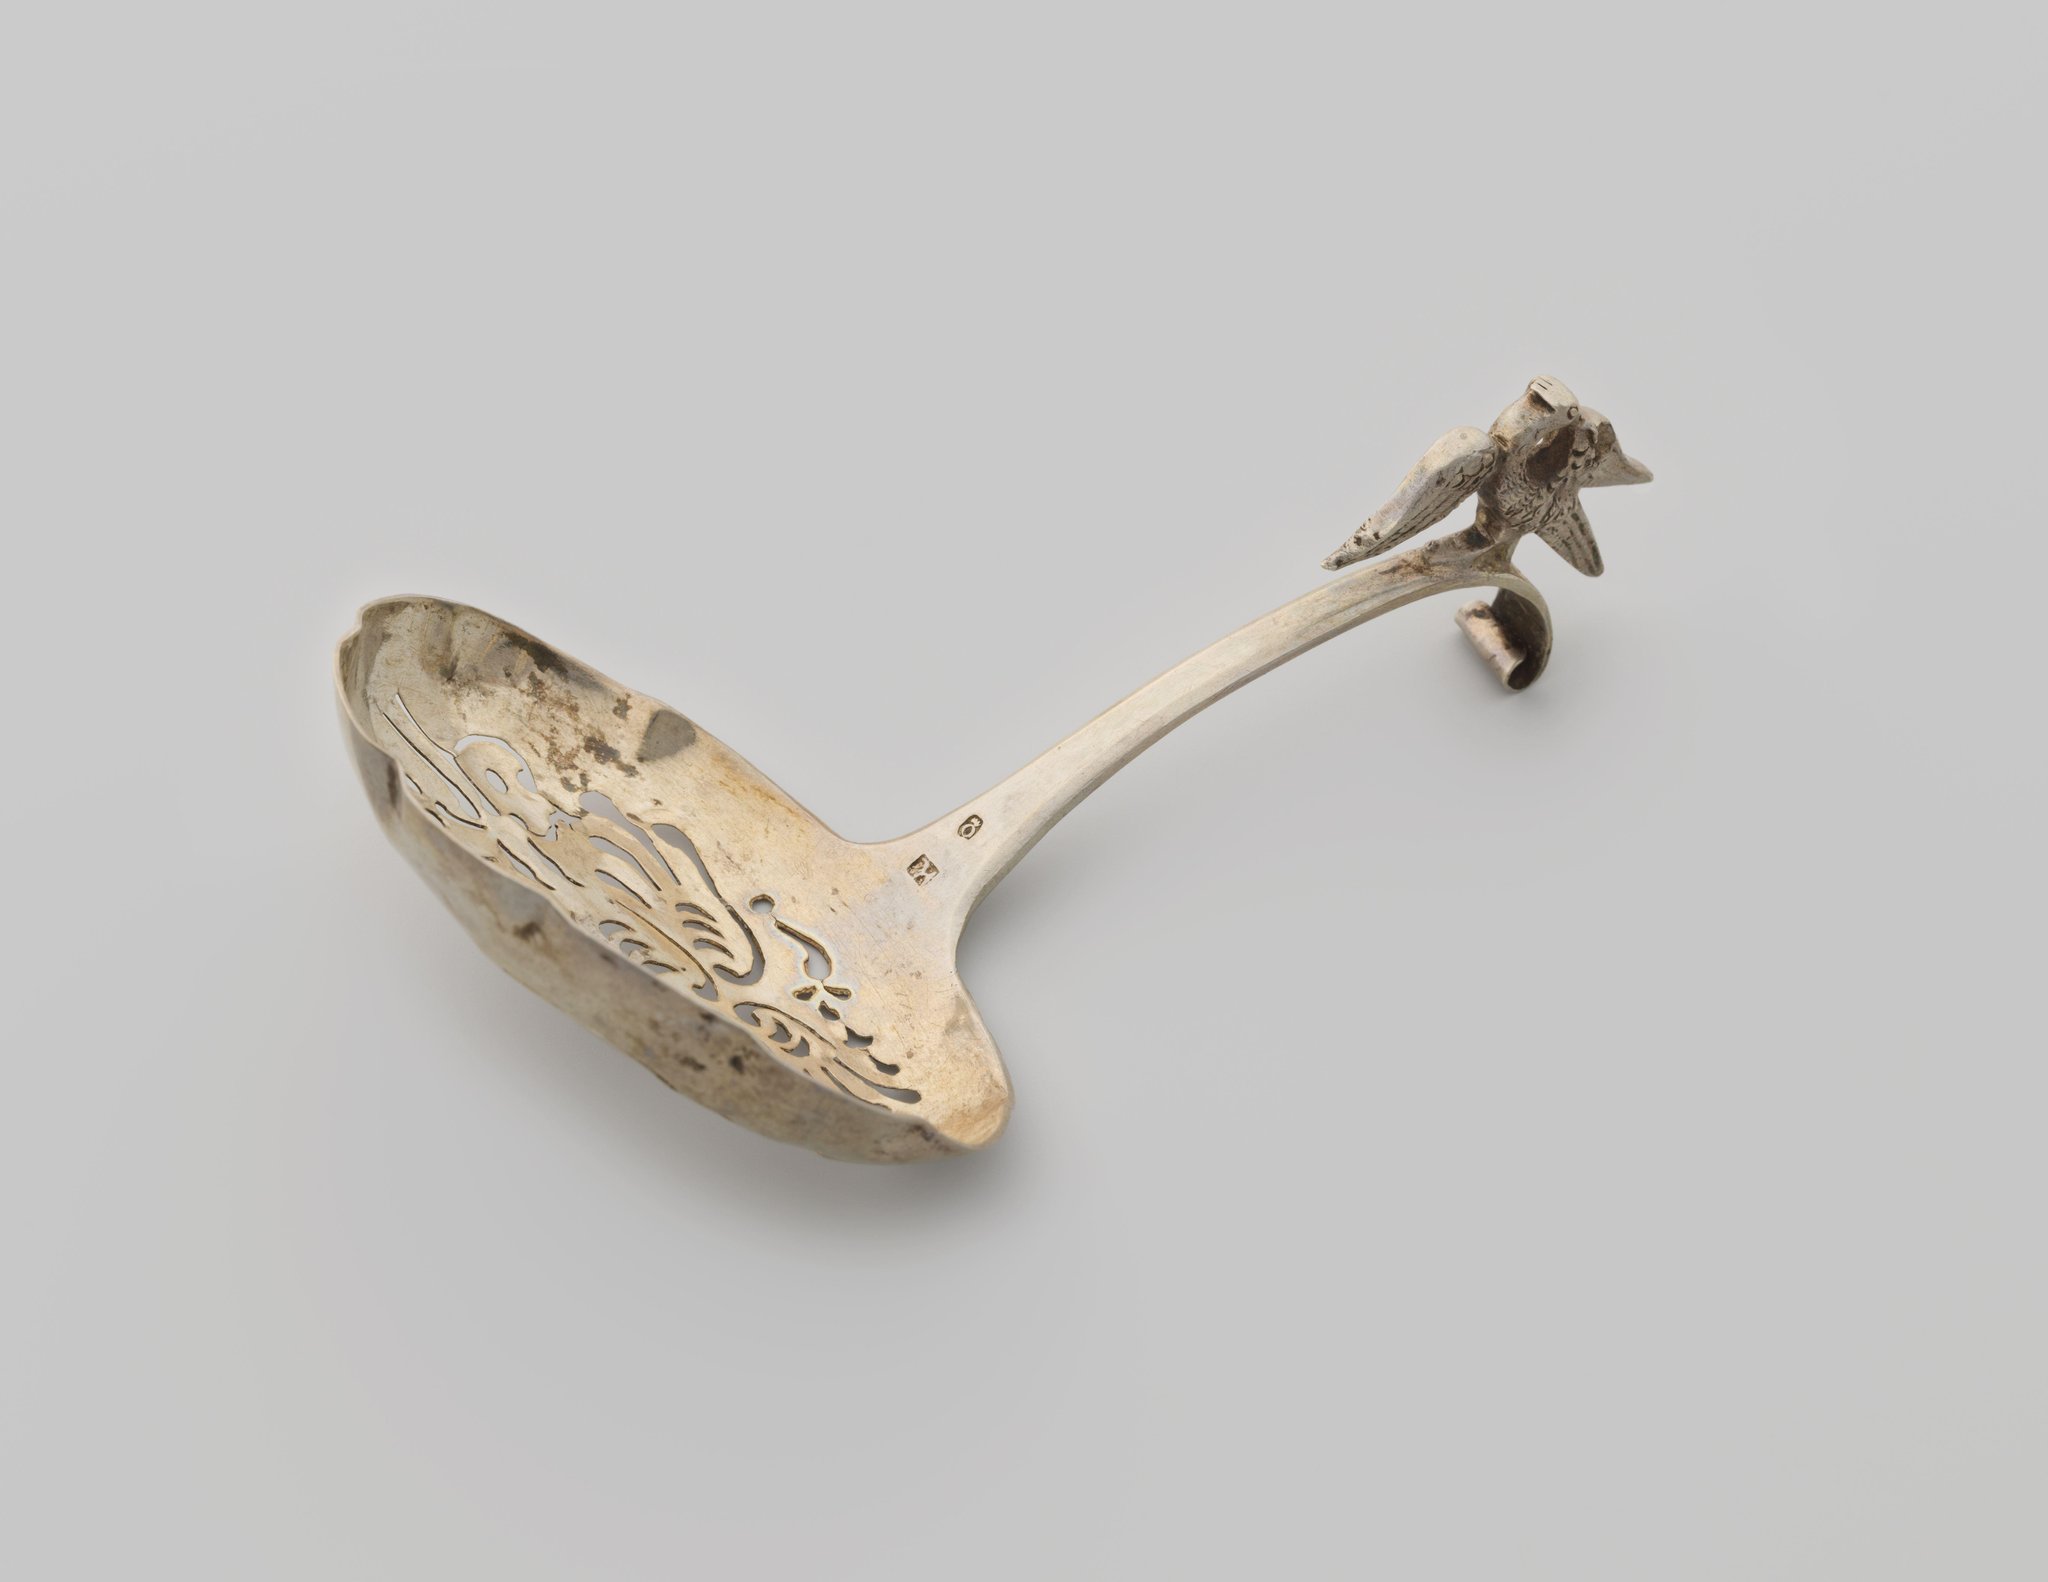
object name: spoon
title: Strooilepel van zilver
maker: Anonymous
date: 1400-1950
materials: silver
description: Zilveren strooilepel met eenkorte omgebogen steel die bekroond wordt door een vogel. De brede bak heeft een geschulpte rand en een asymmetrisch opengewerkt décor Merk: een vogel en een herkeur.